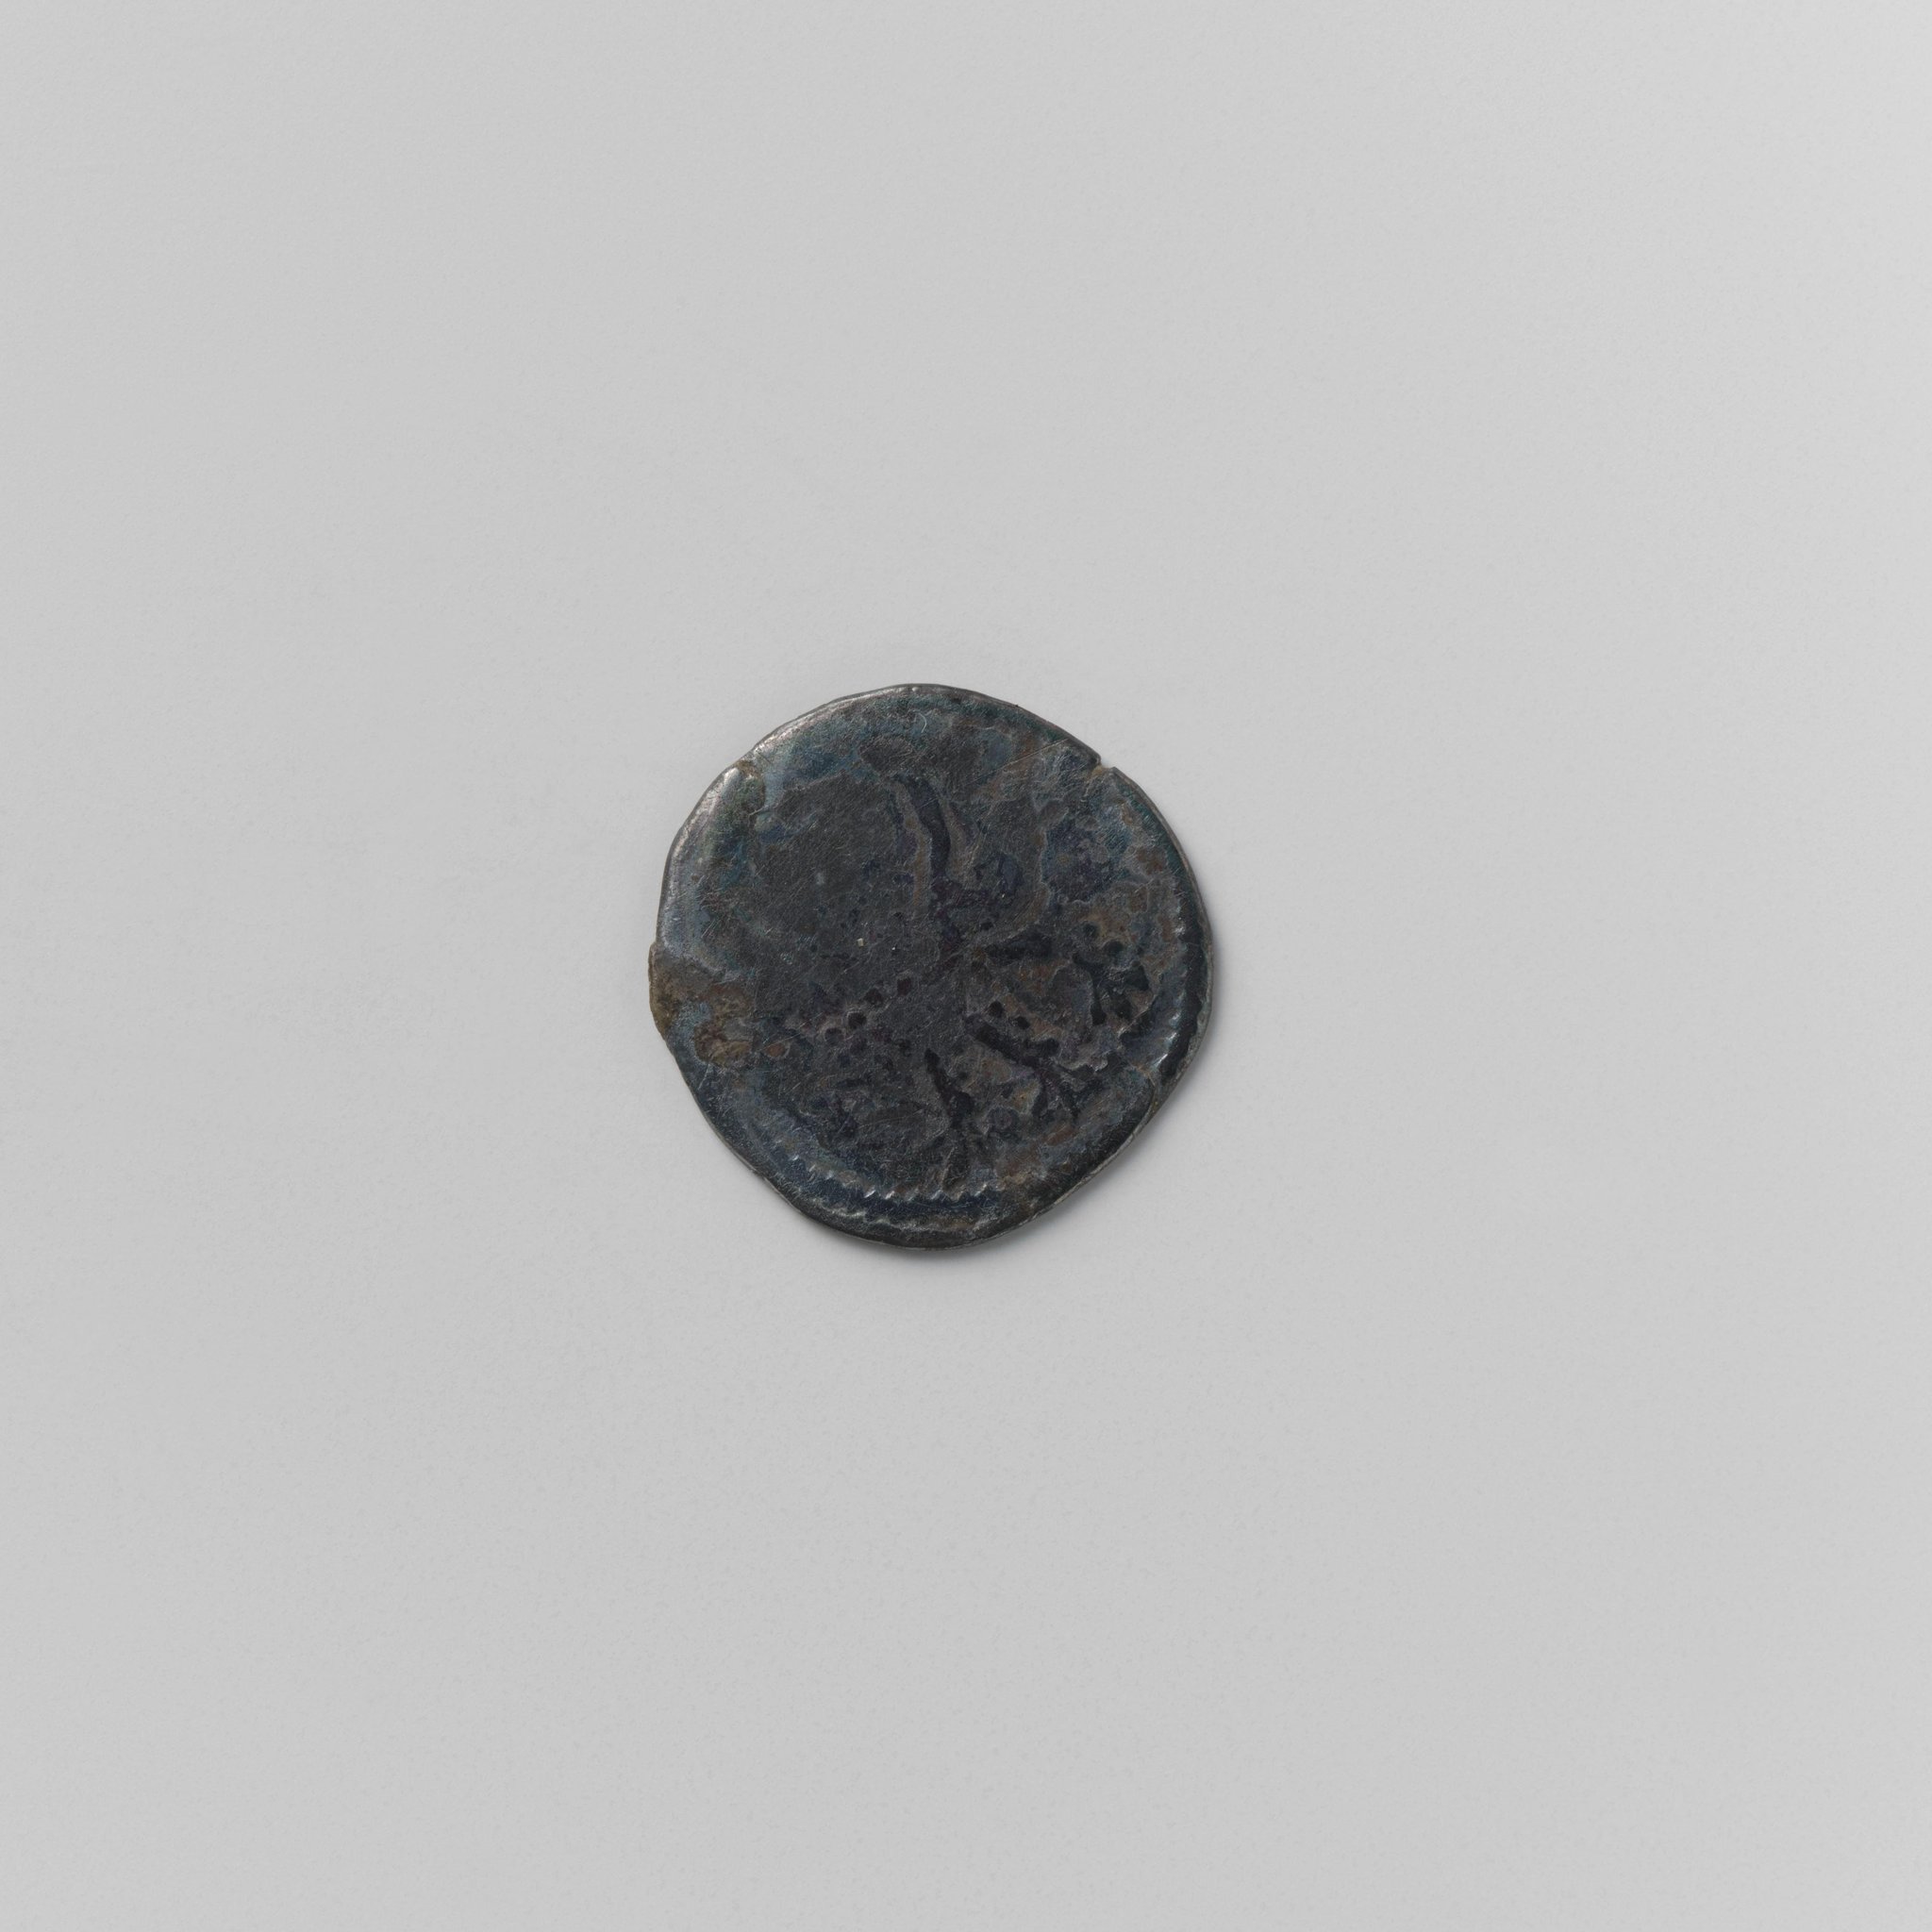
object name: coin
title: Brabant, Jan I, penning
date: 1268-1294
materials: silver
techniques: striking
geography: brussels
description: Voorzijde: klimmende leeuw naar links. Keerzijde: gevoet kruis, in de hoeken letters I,D,V en X.